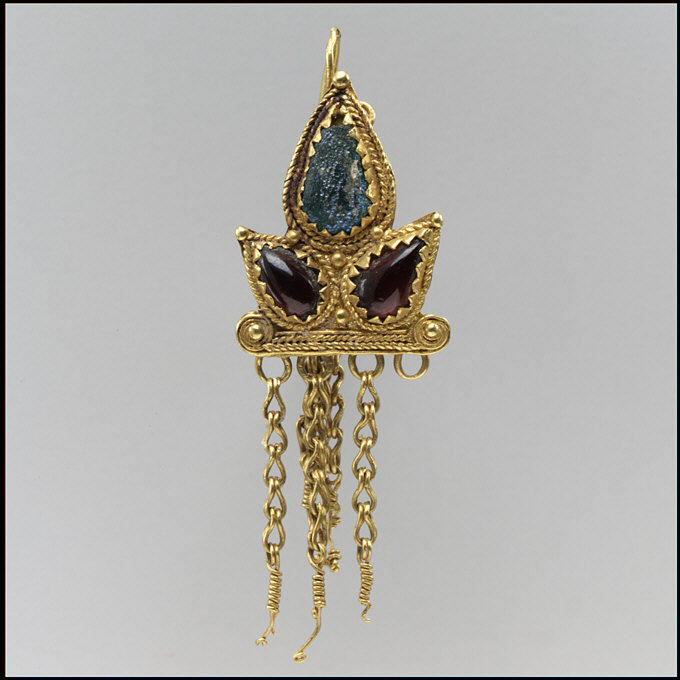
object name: earring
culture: sarmatian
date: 34-66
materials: garnet, glass, gold